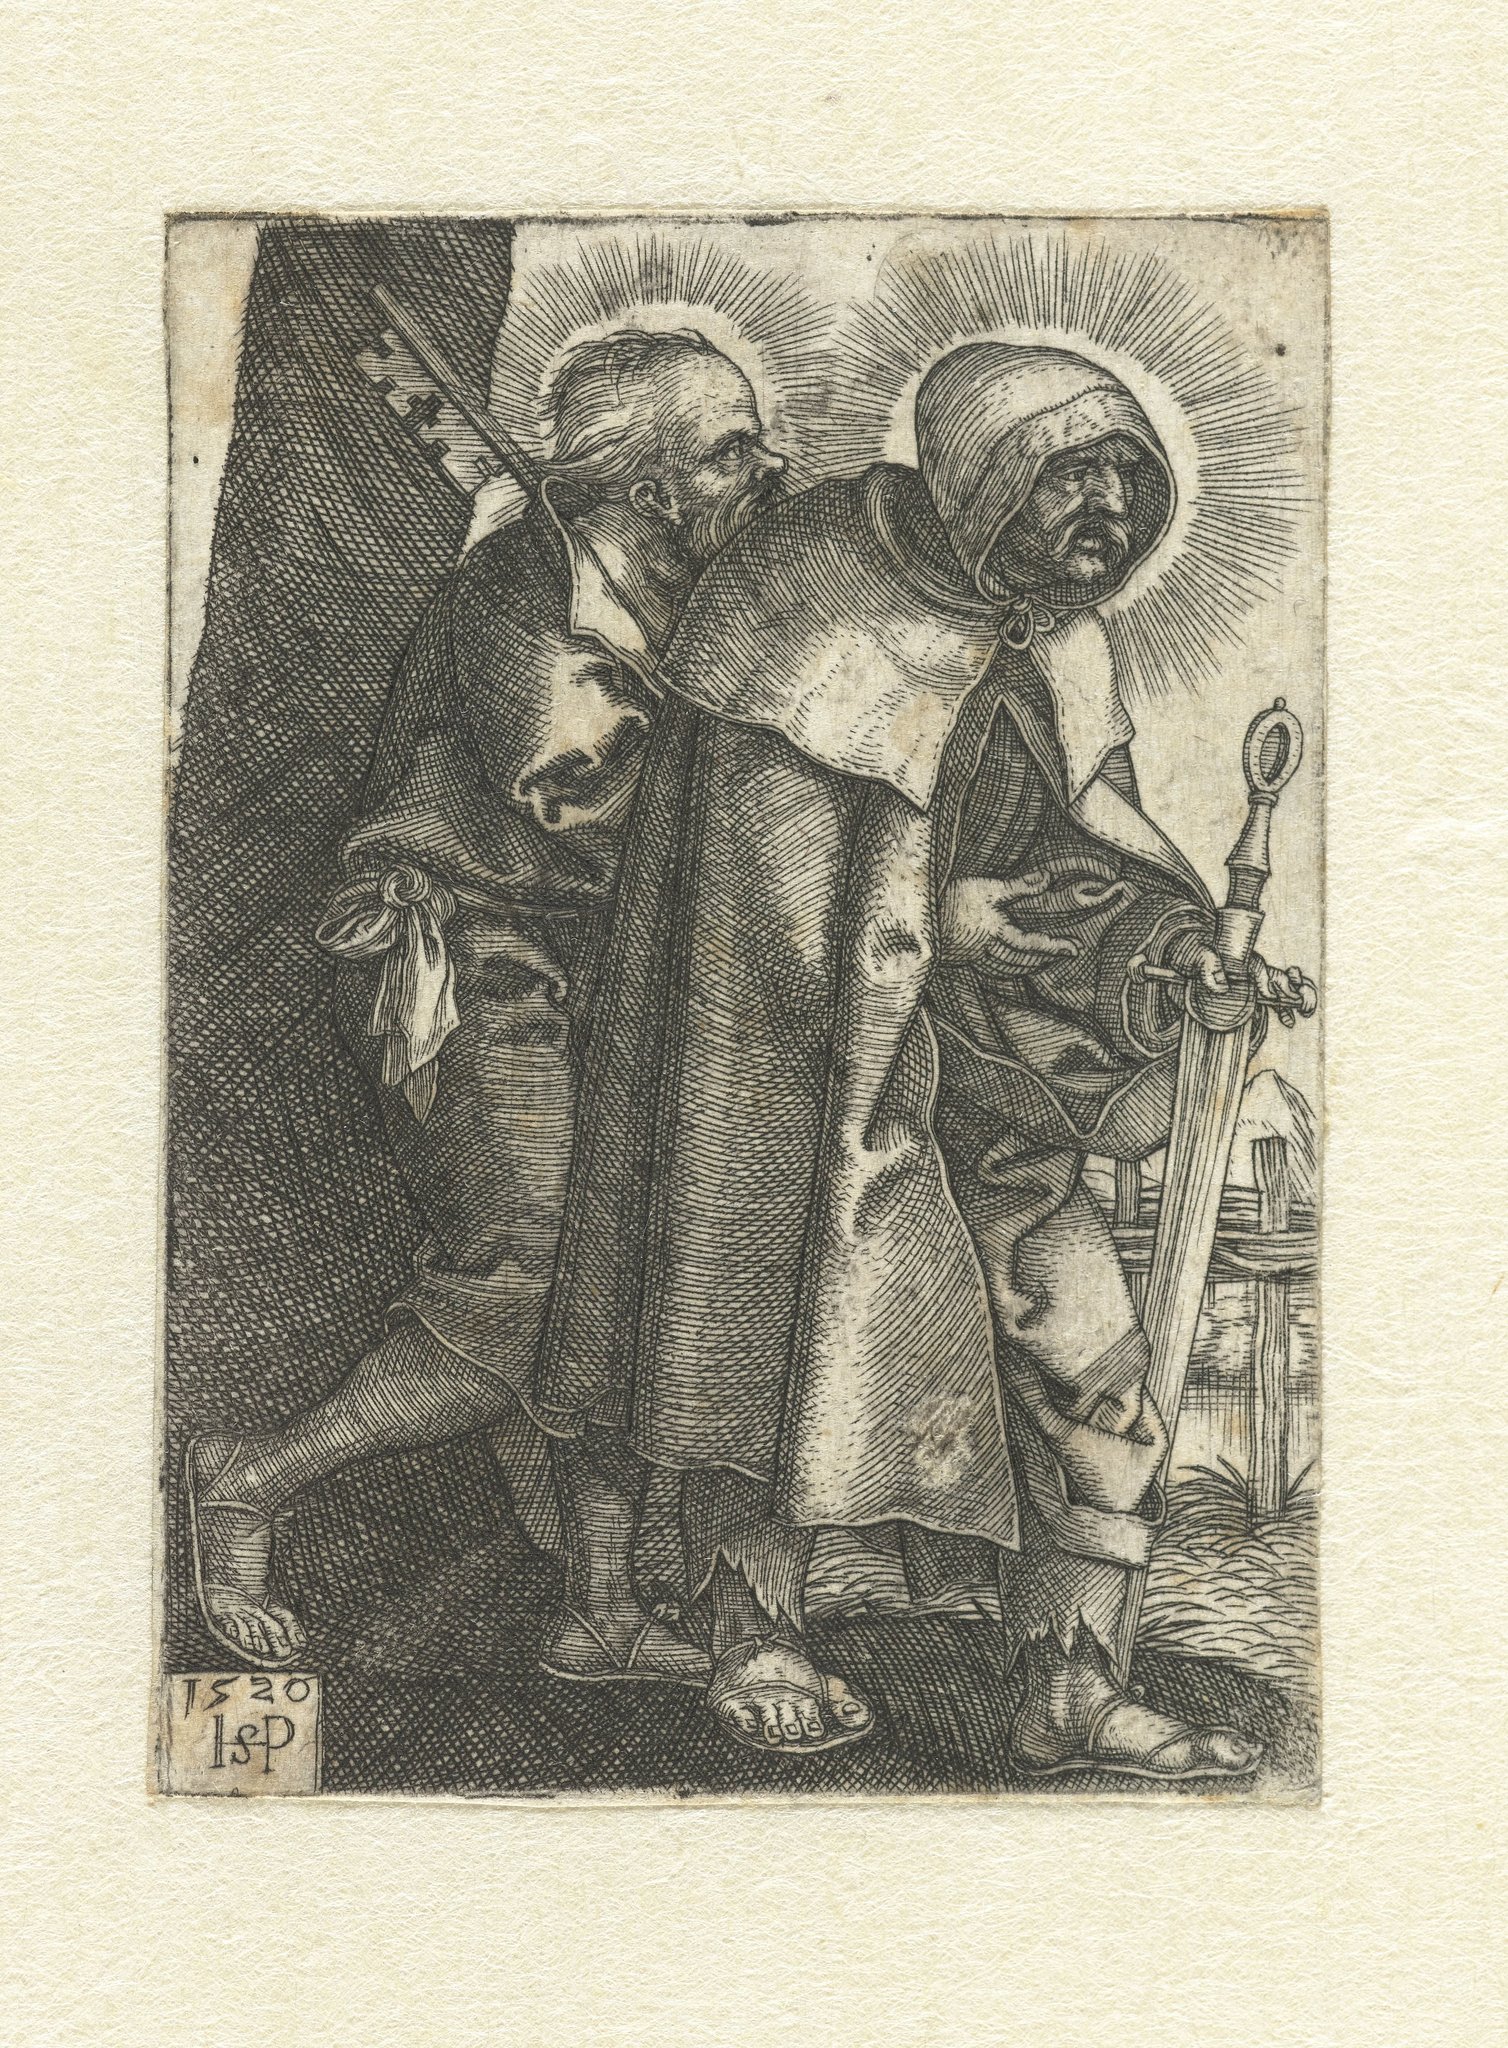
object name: print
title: Christus en de twaalf apostelen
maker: hans sebald beham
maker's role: designer, draughtsman, print maker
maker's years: 1500-1550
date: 1520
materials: paper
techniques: engraving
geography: nuremberg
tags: the apostle peter, first bishop of rome; possible attributes: book, cock, (upturned) cross, (triple) crozier, fish, key, scroll, ship, tiara, the apostle paul of tarsus; possible attributes: book, scroll, sword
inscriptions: collector's mark: Lugt 240